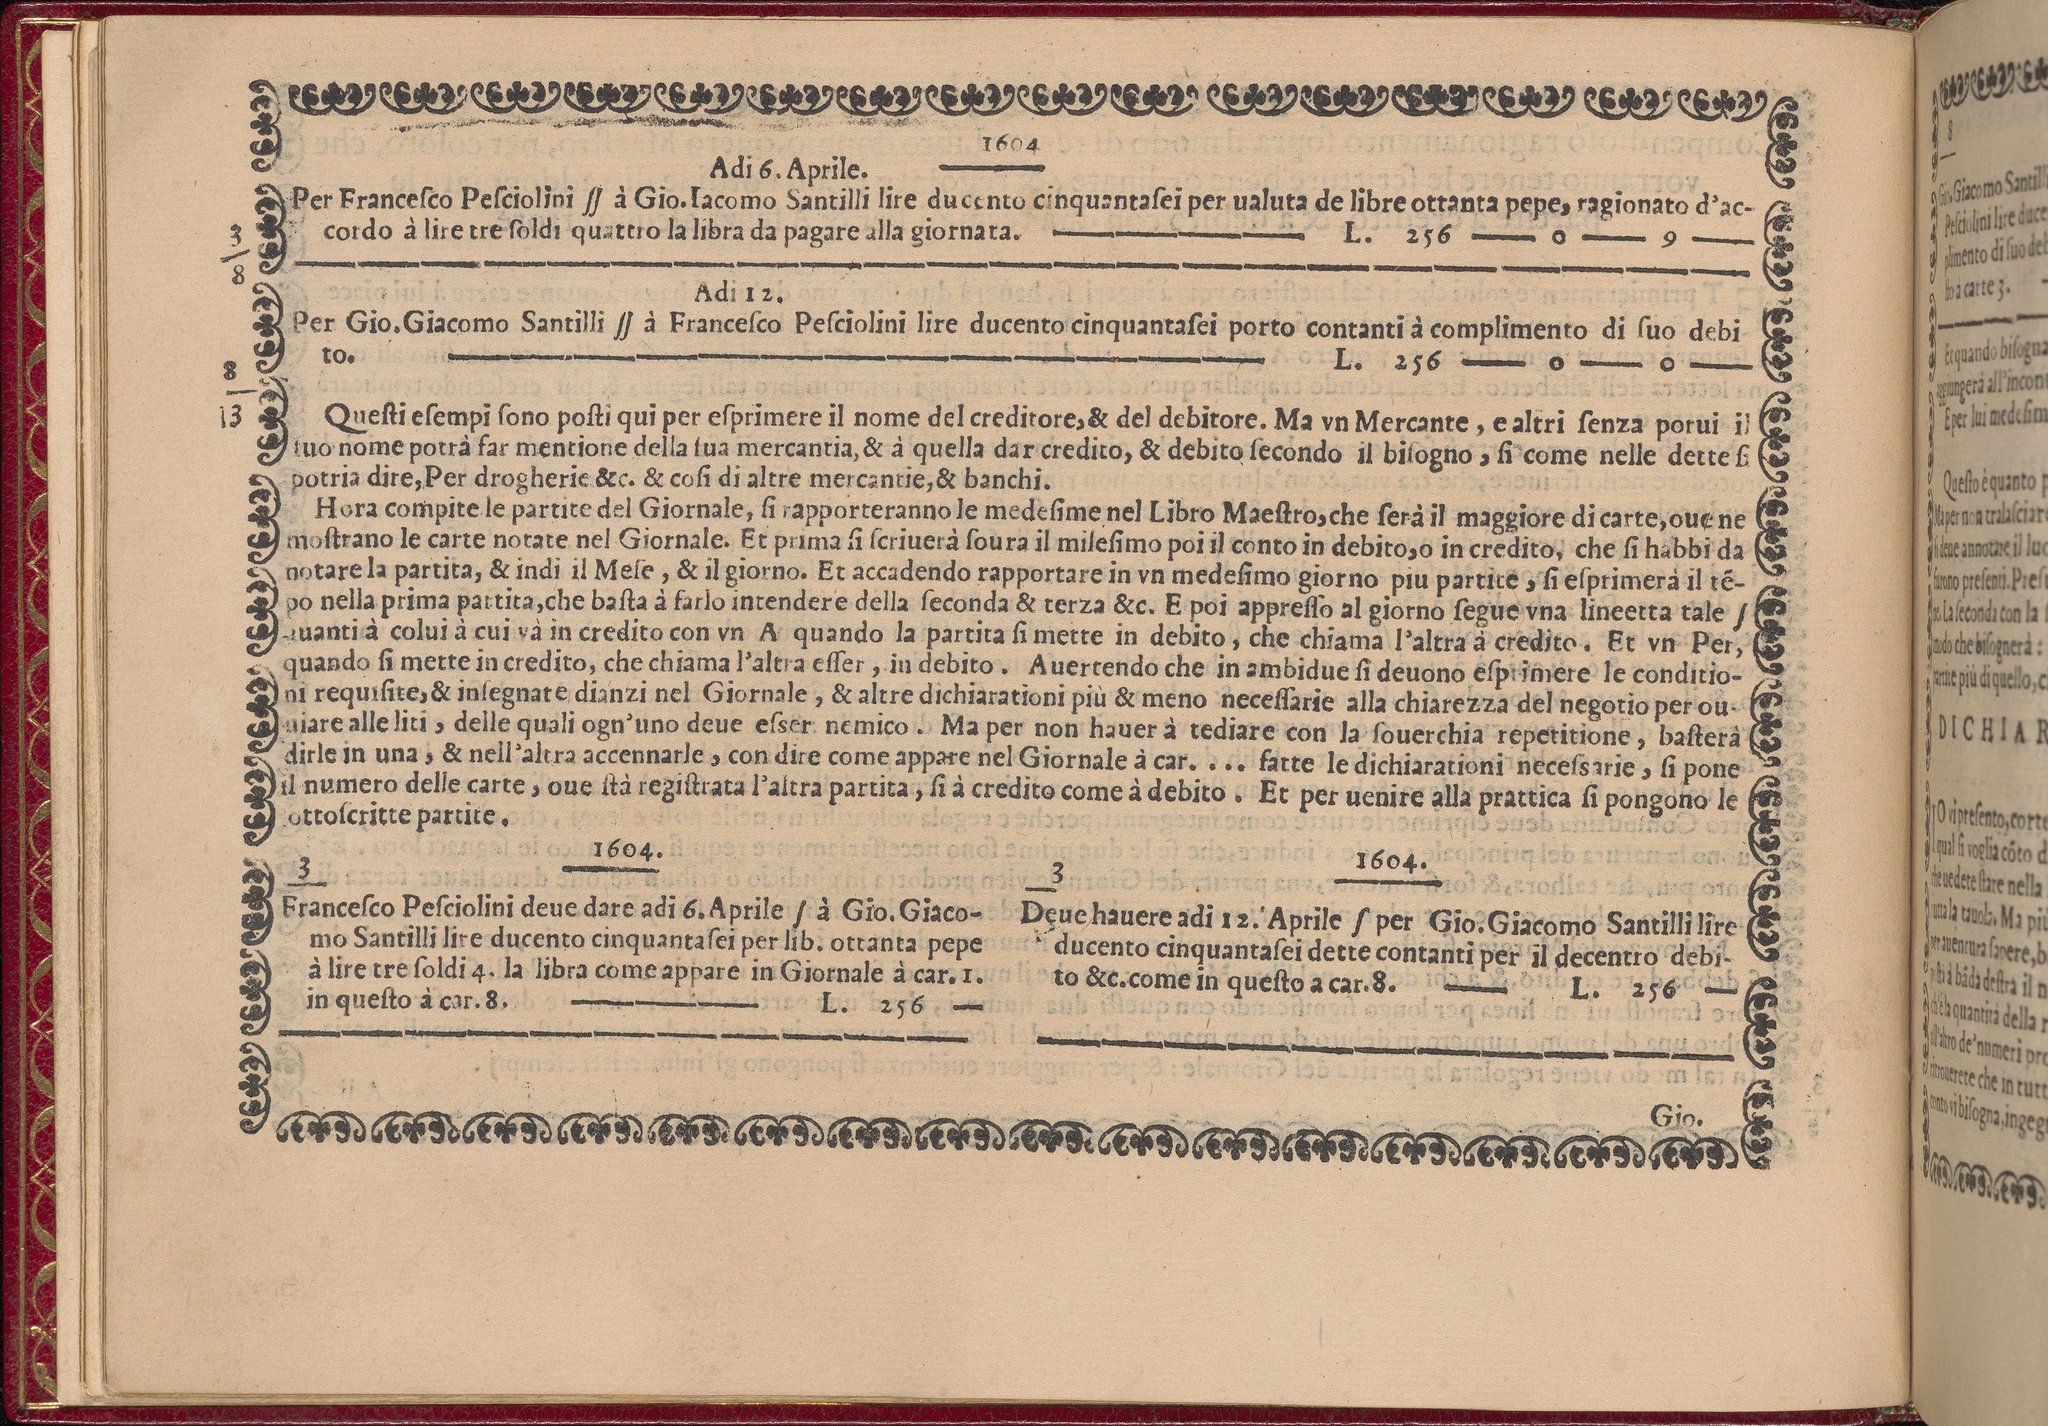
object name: book print ornament architecture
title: Ghirlanda: Di sei vaghi fiori scielti da piu famosi Giardini d'Italia, page 7 (verso)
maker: pietro paulo tozzi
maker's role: designer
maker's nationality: italian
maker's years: 1593-1628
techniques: drawing, etching